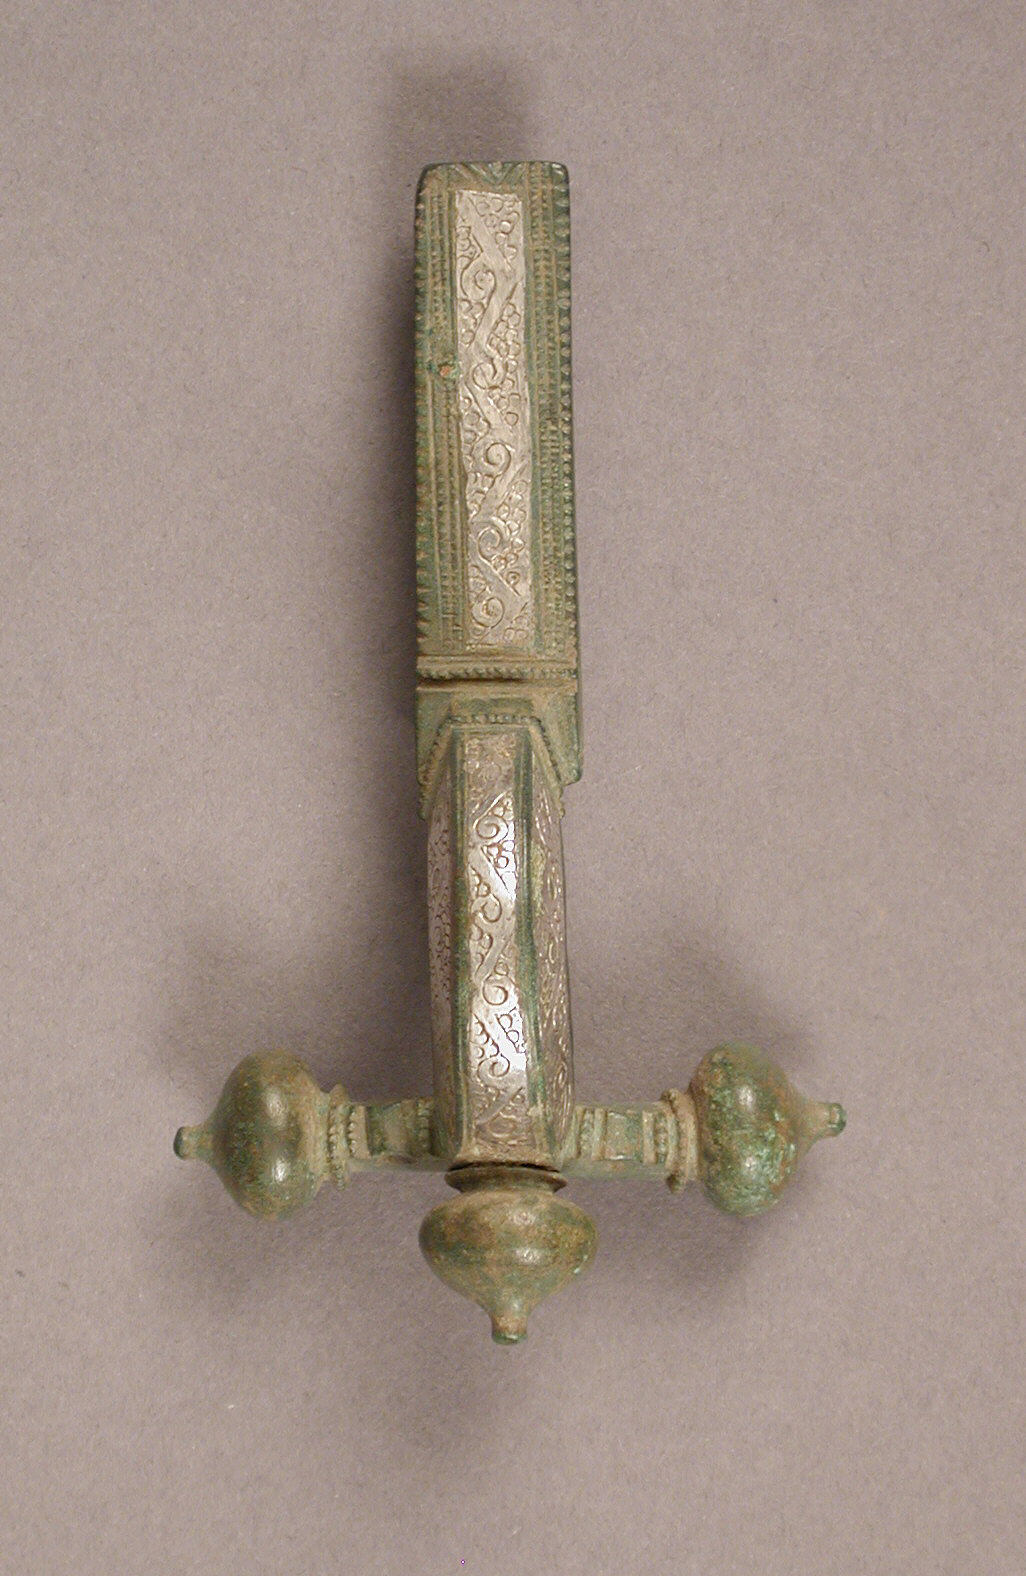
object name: brooch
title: Crossbow Brooch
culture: late roman or byzantine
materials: copper alloy, silver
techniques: casting, inlay